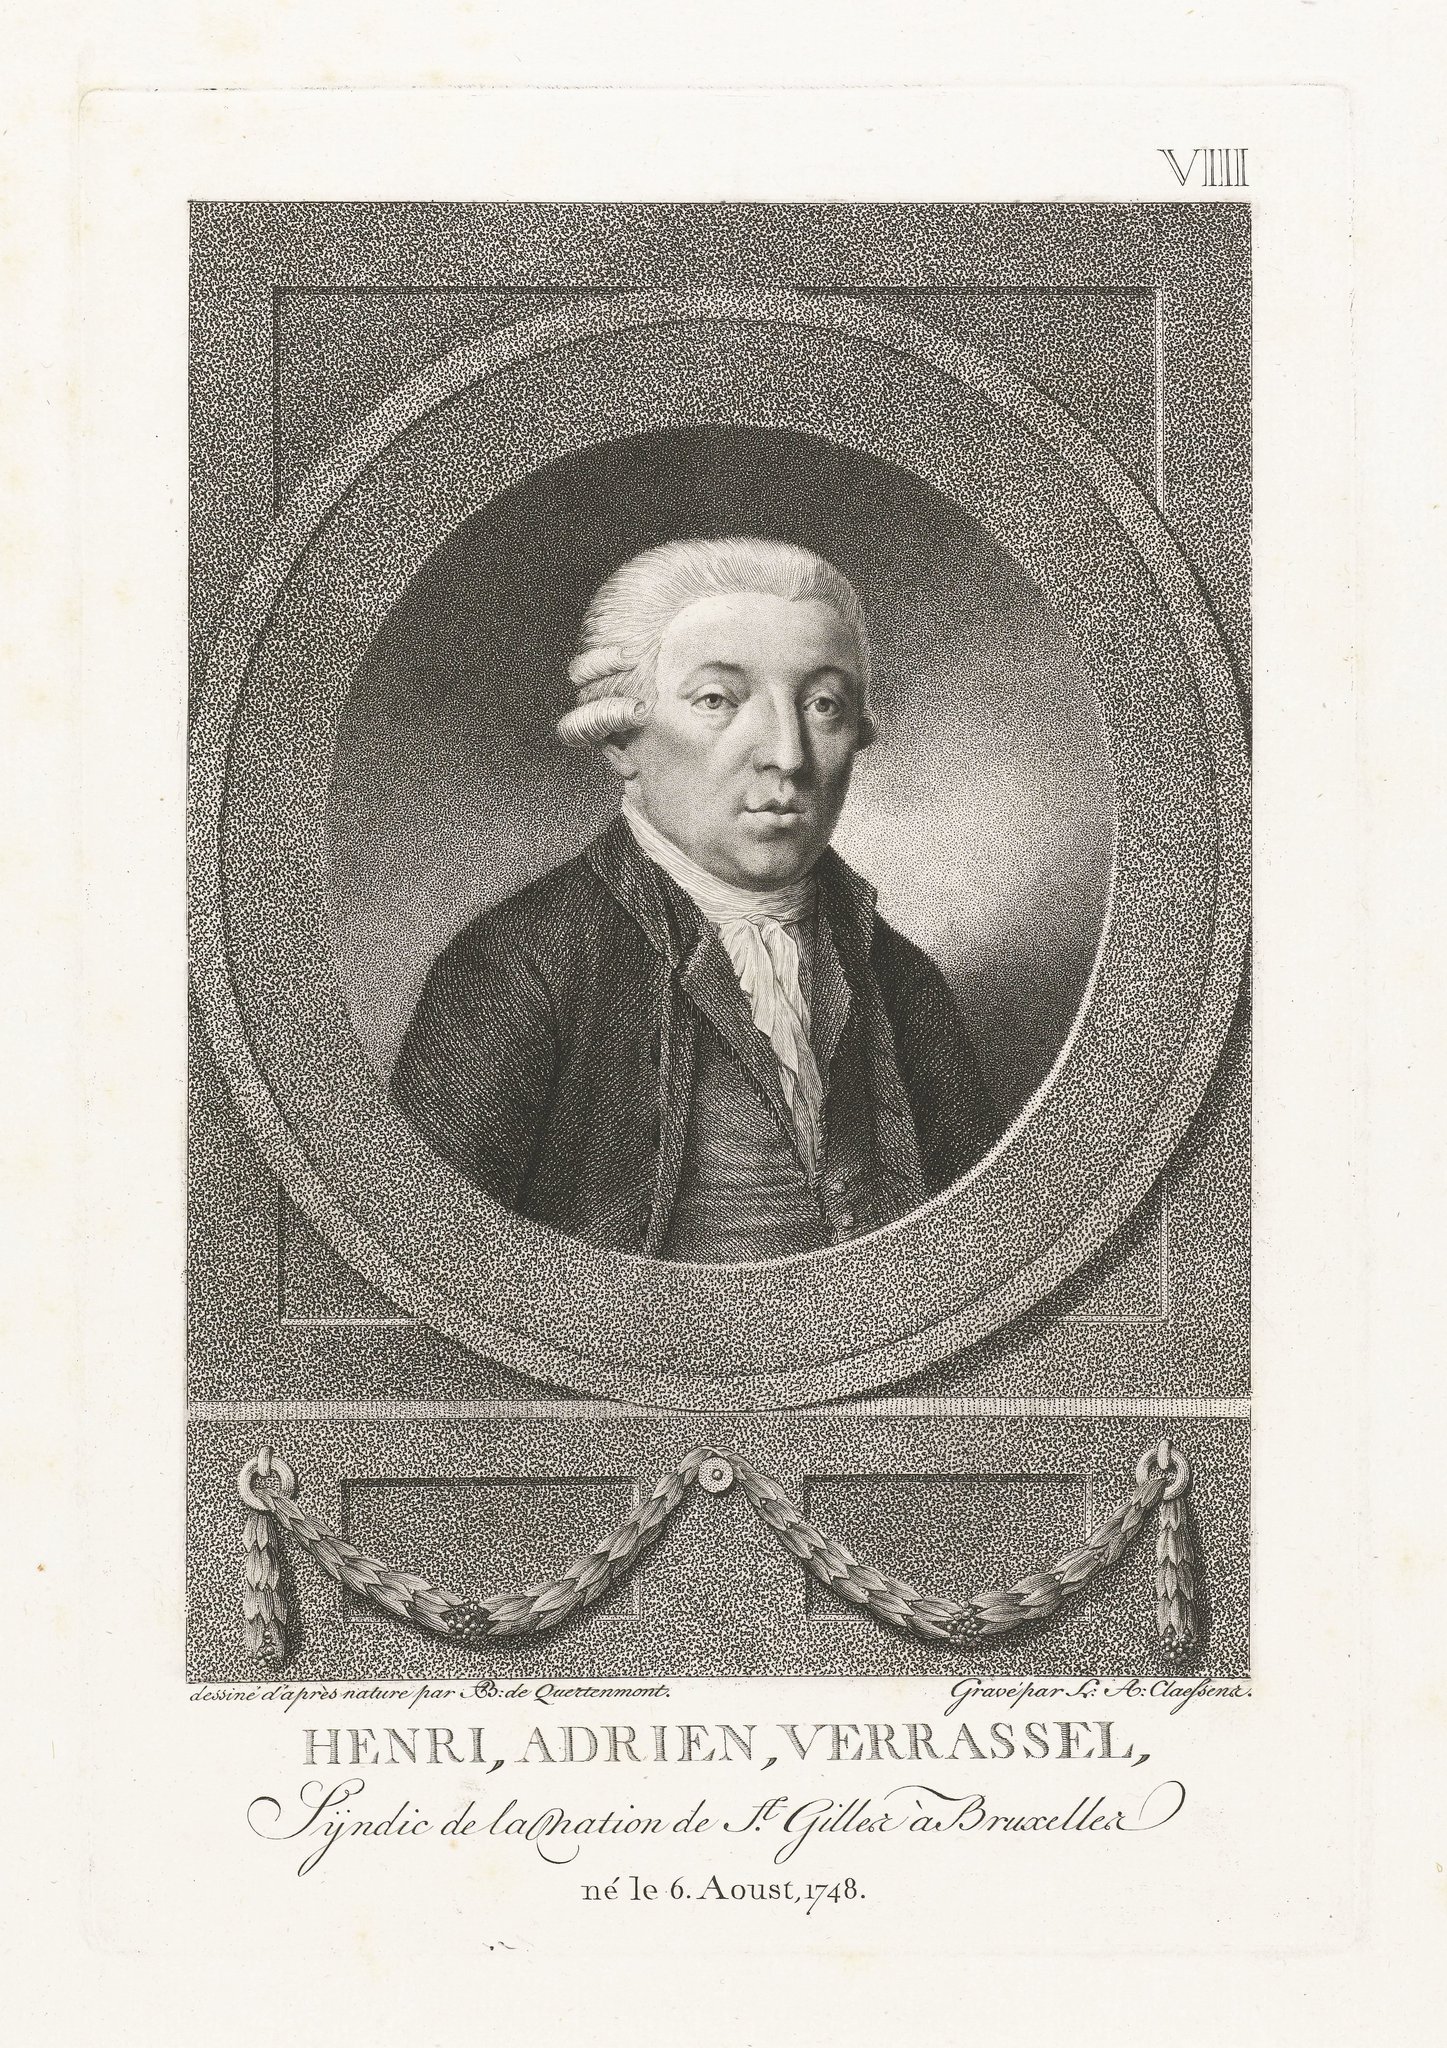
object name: print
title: Portret van Henri Adriaen Verrassel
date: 1792-1834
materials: paper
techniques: engraving, etching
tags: staatsman, henri adrien verrassel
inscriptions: collector's mark: Lugt 2228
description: Portretbuste van Henri Adrien Verrassel, in medaillon. Onder het portret een guirlande en zijn naam en functies.